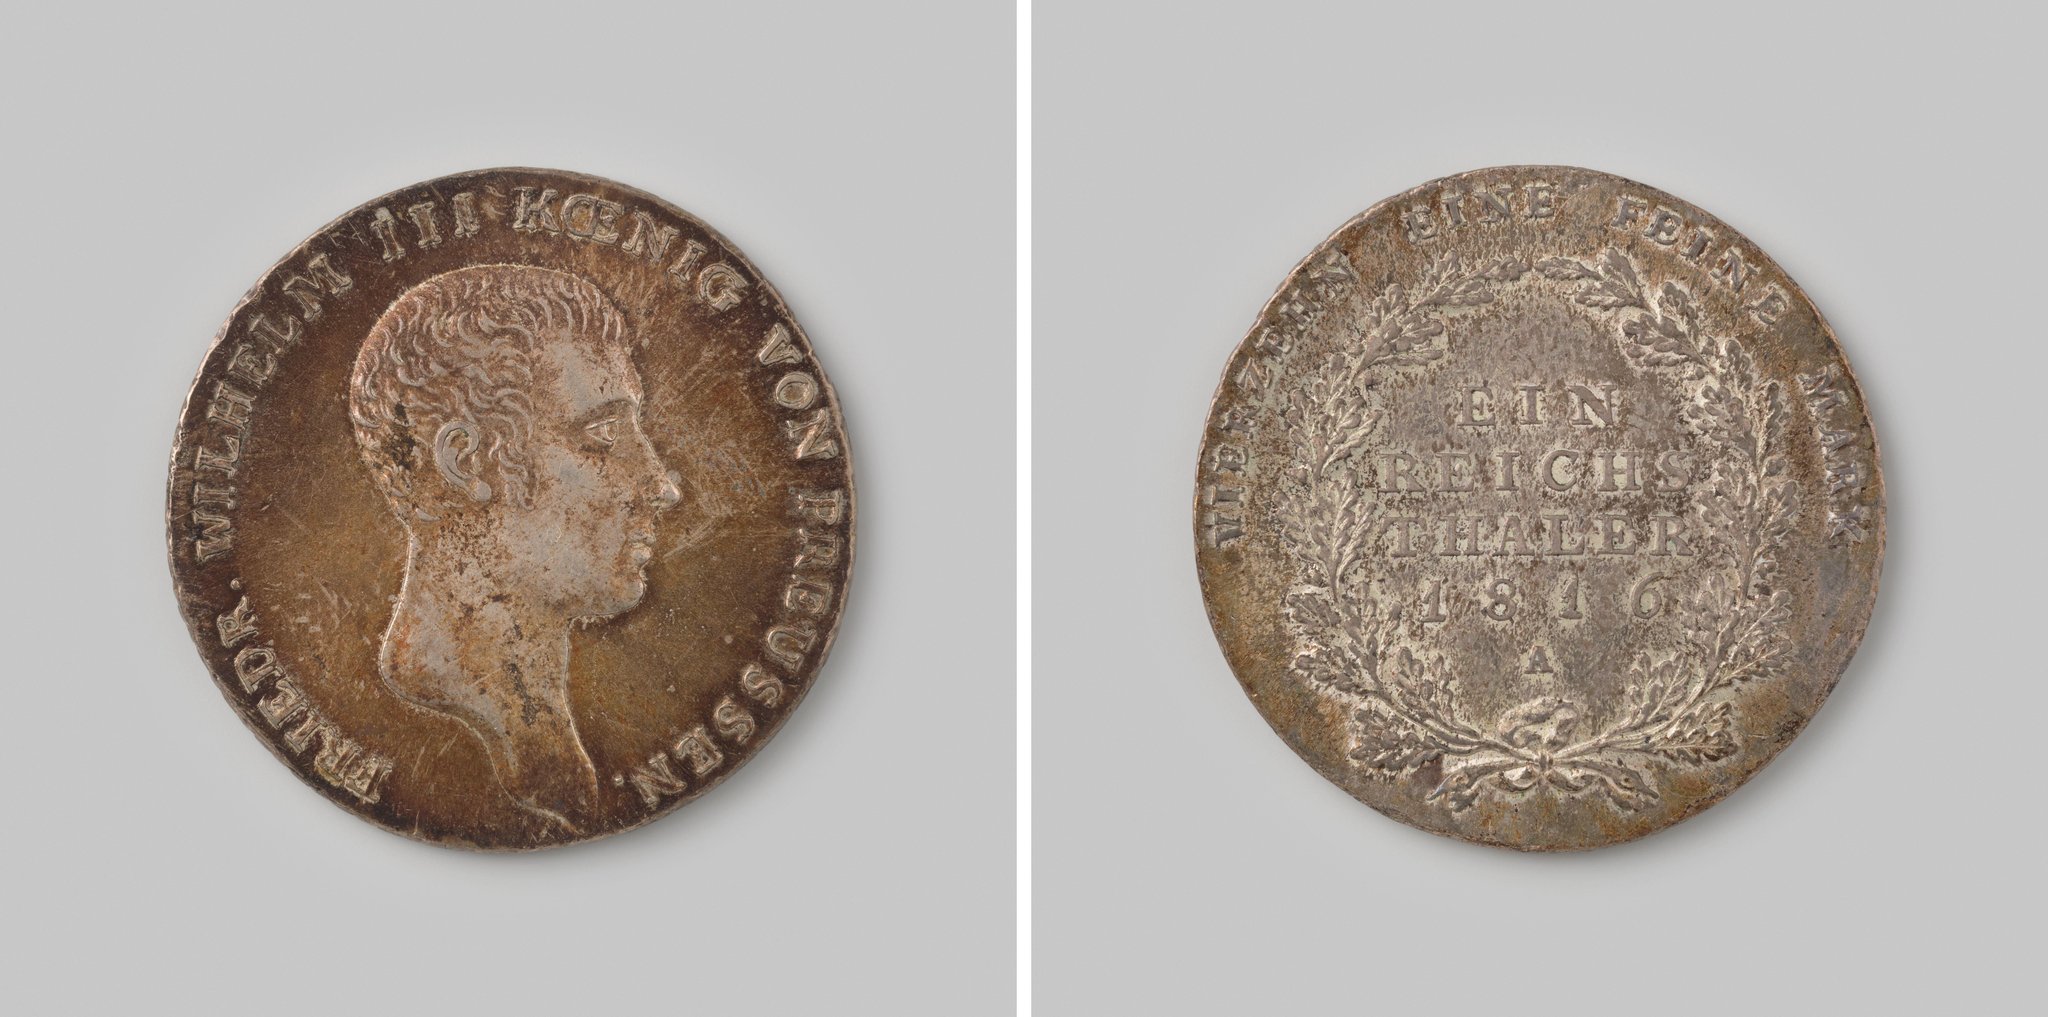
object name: coin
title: Reichstaler uit Pruisen van Friedrich Wilhelm III, 1816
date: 1816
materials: silver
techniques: striking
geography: berlin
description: Zilveren munt. Voorzijde: hoofd van de koning naar rechts. Keerzijde: binnen twee samengebonden eiketakken waarde-aanduiding in drie regels: Ein Reichs Thaler. Daaronder jaartal, waaronder letter A. Kartelrand.